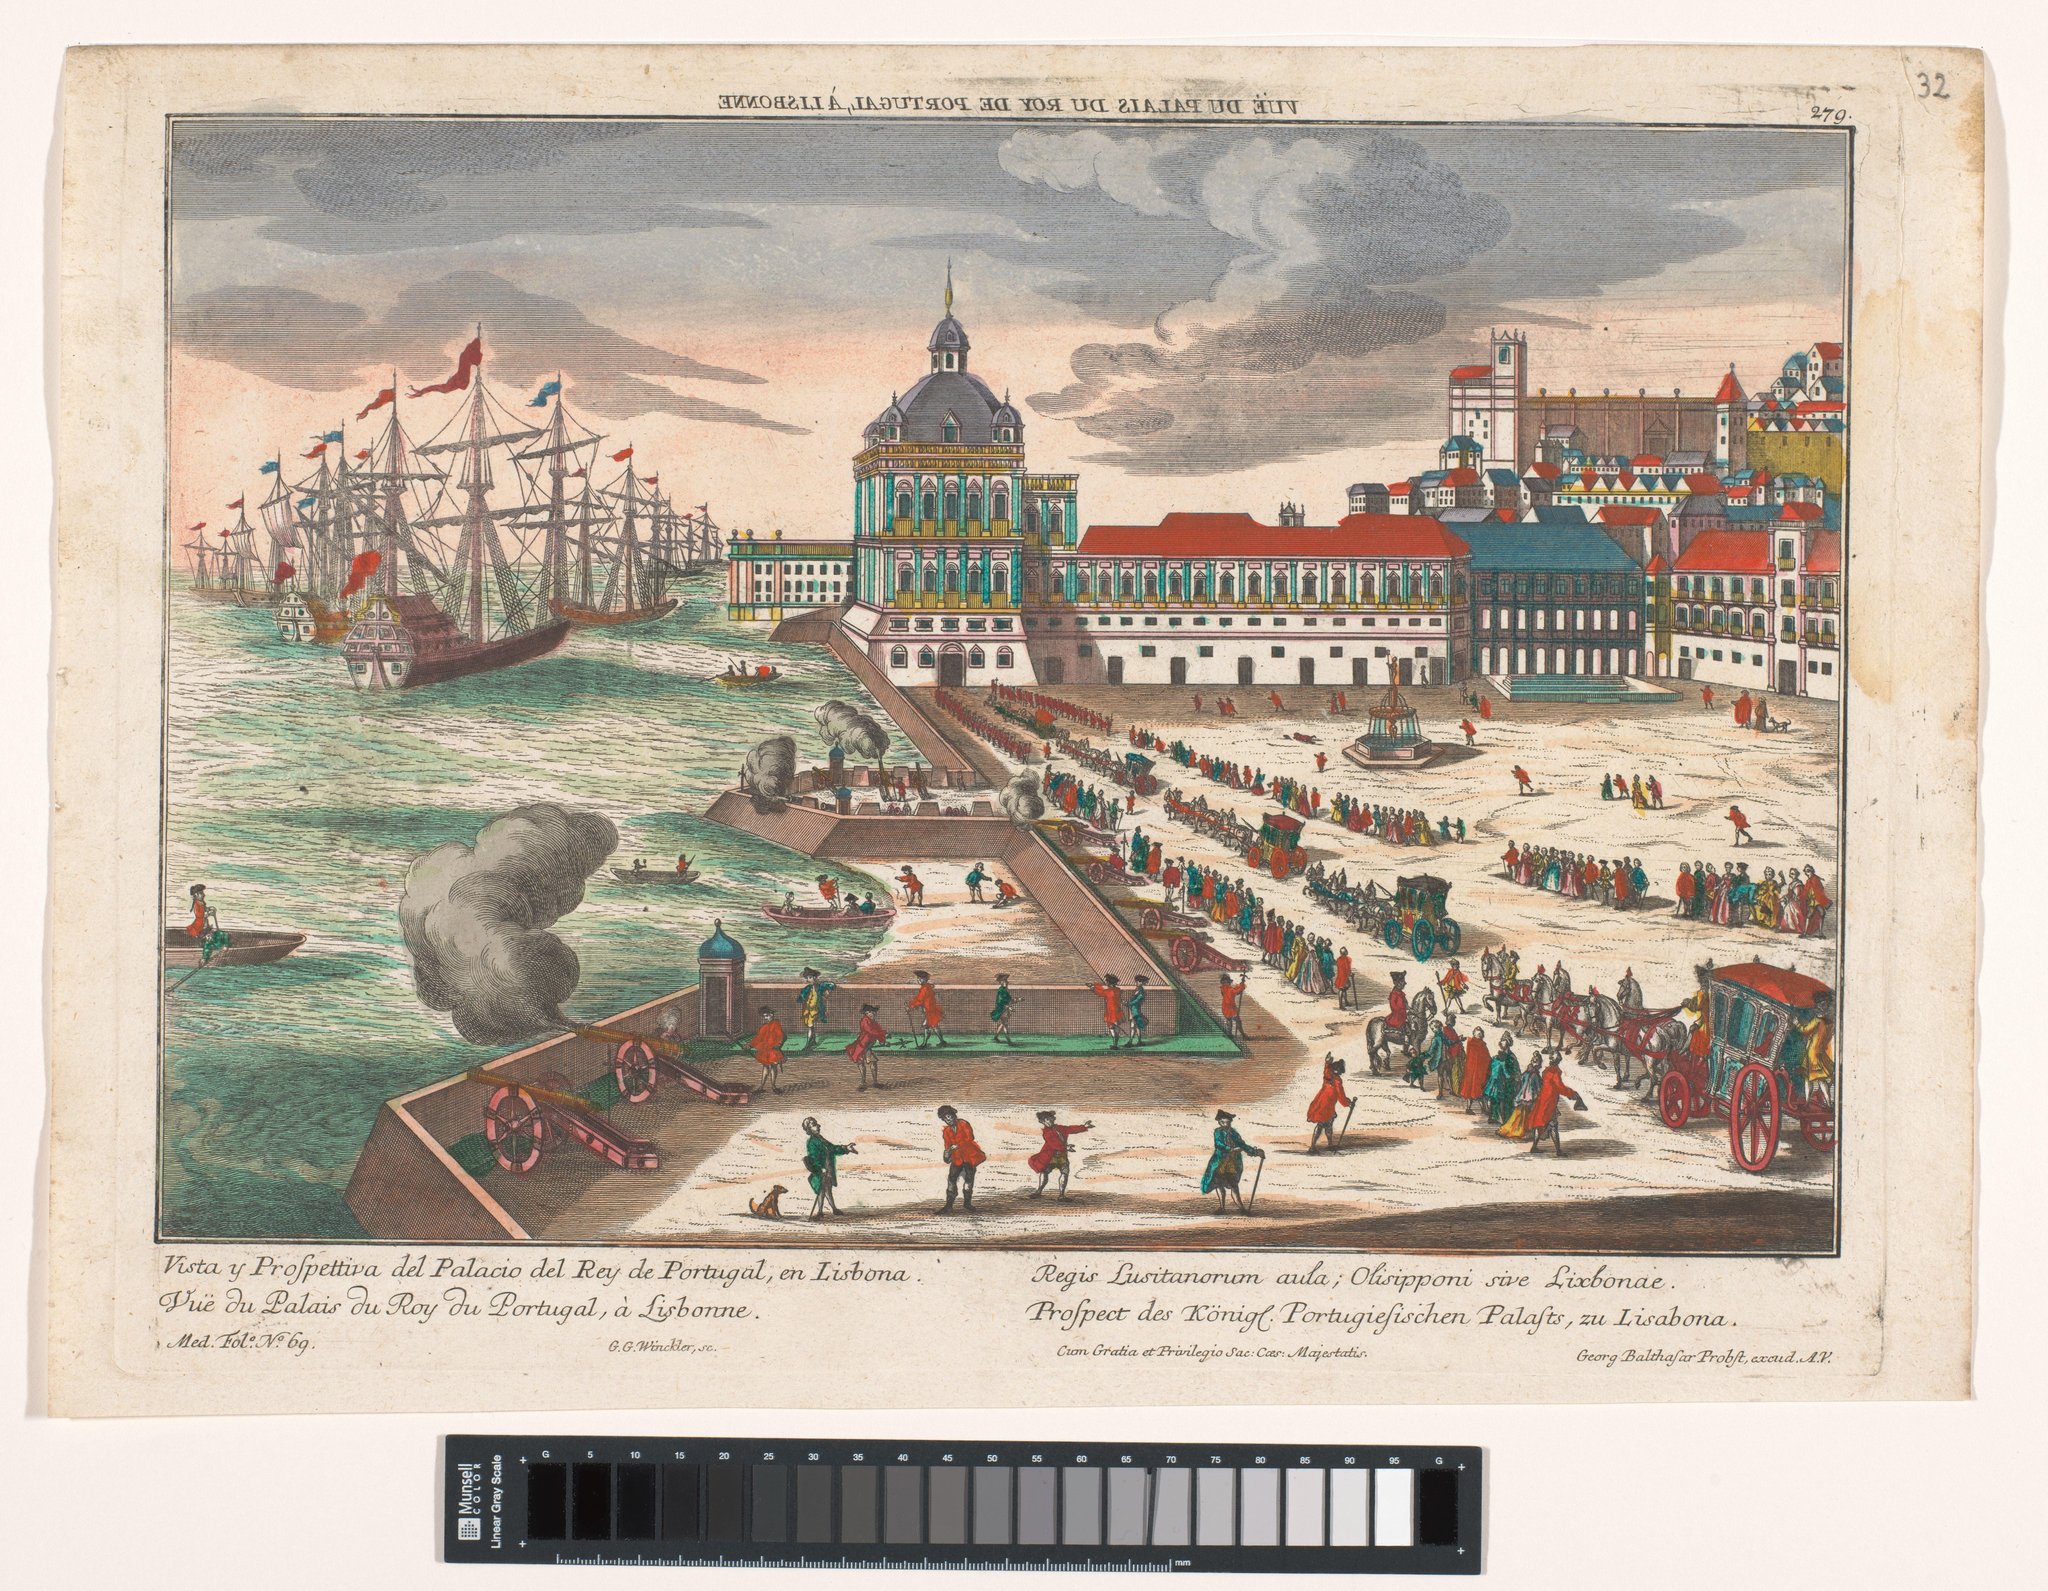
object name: opticaprent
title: Lissabon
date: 1742-1801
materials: paper, watercolor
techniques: brush, etching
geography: augsburg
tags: sailing-ship, sailing-boat, palace, rowing-boat, canoe, etc., firearms: cannon, military parade, pageant, sea (seascape) (+ landscape with figures, staffage), square, place, circus, etc. (+ city(-scape) with figures, staffage), ornamental fountain (+ city(-scape) with figures, staffage), canals, waters (in city) (+ city(-scape) with figures, staffage)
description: Links de rivier de Taag met daarachter de zee. In het midden vuurt een aantal figuren kanonnen af en loopt een stoet naar de ingang van het paleis. Rechtsboven genummerd: 279. Linksonder genummerd: 69.